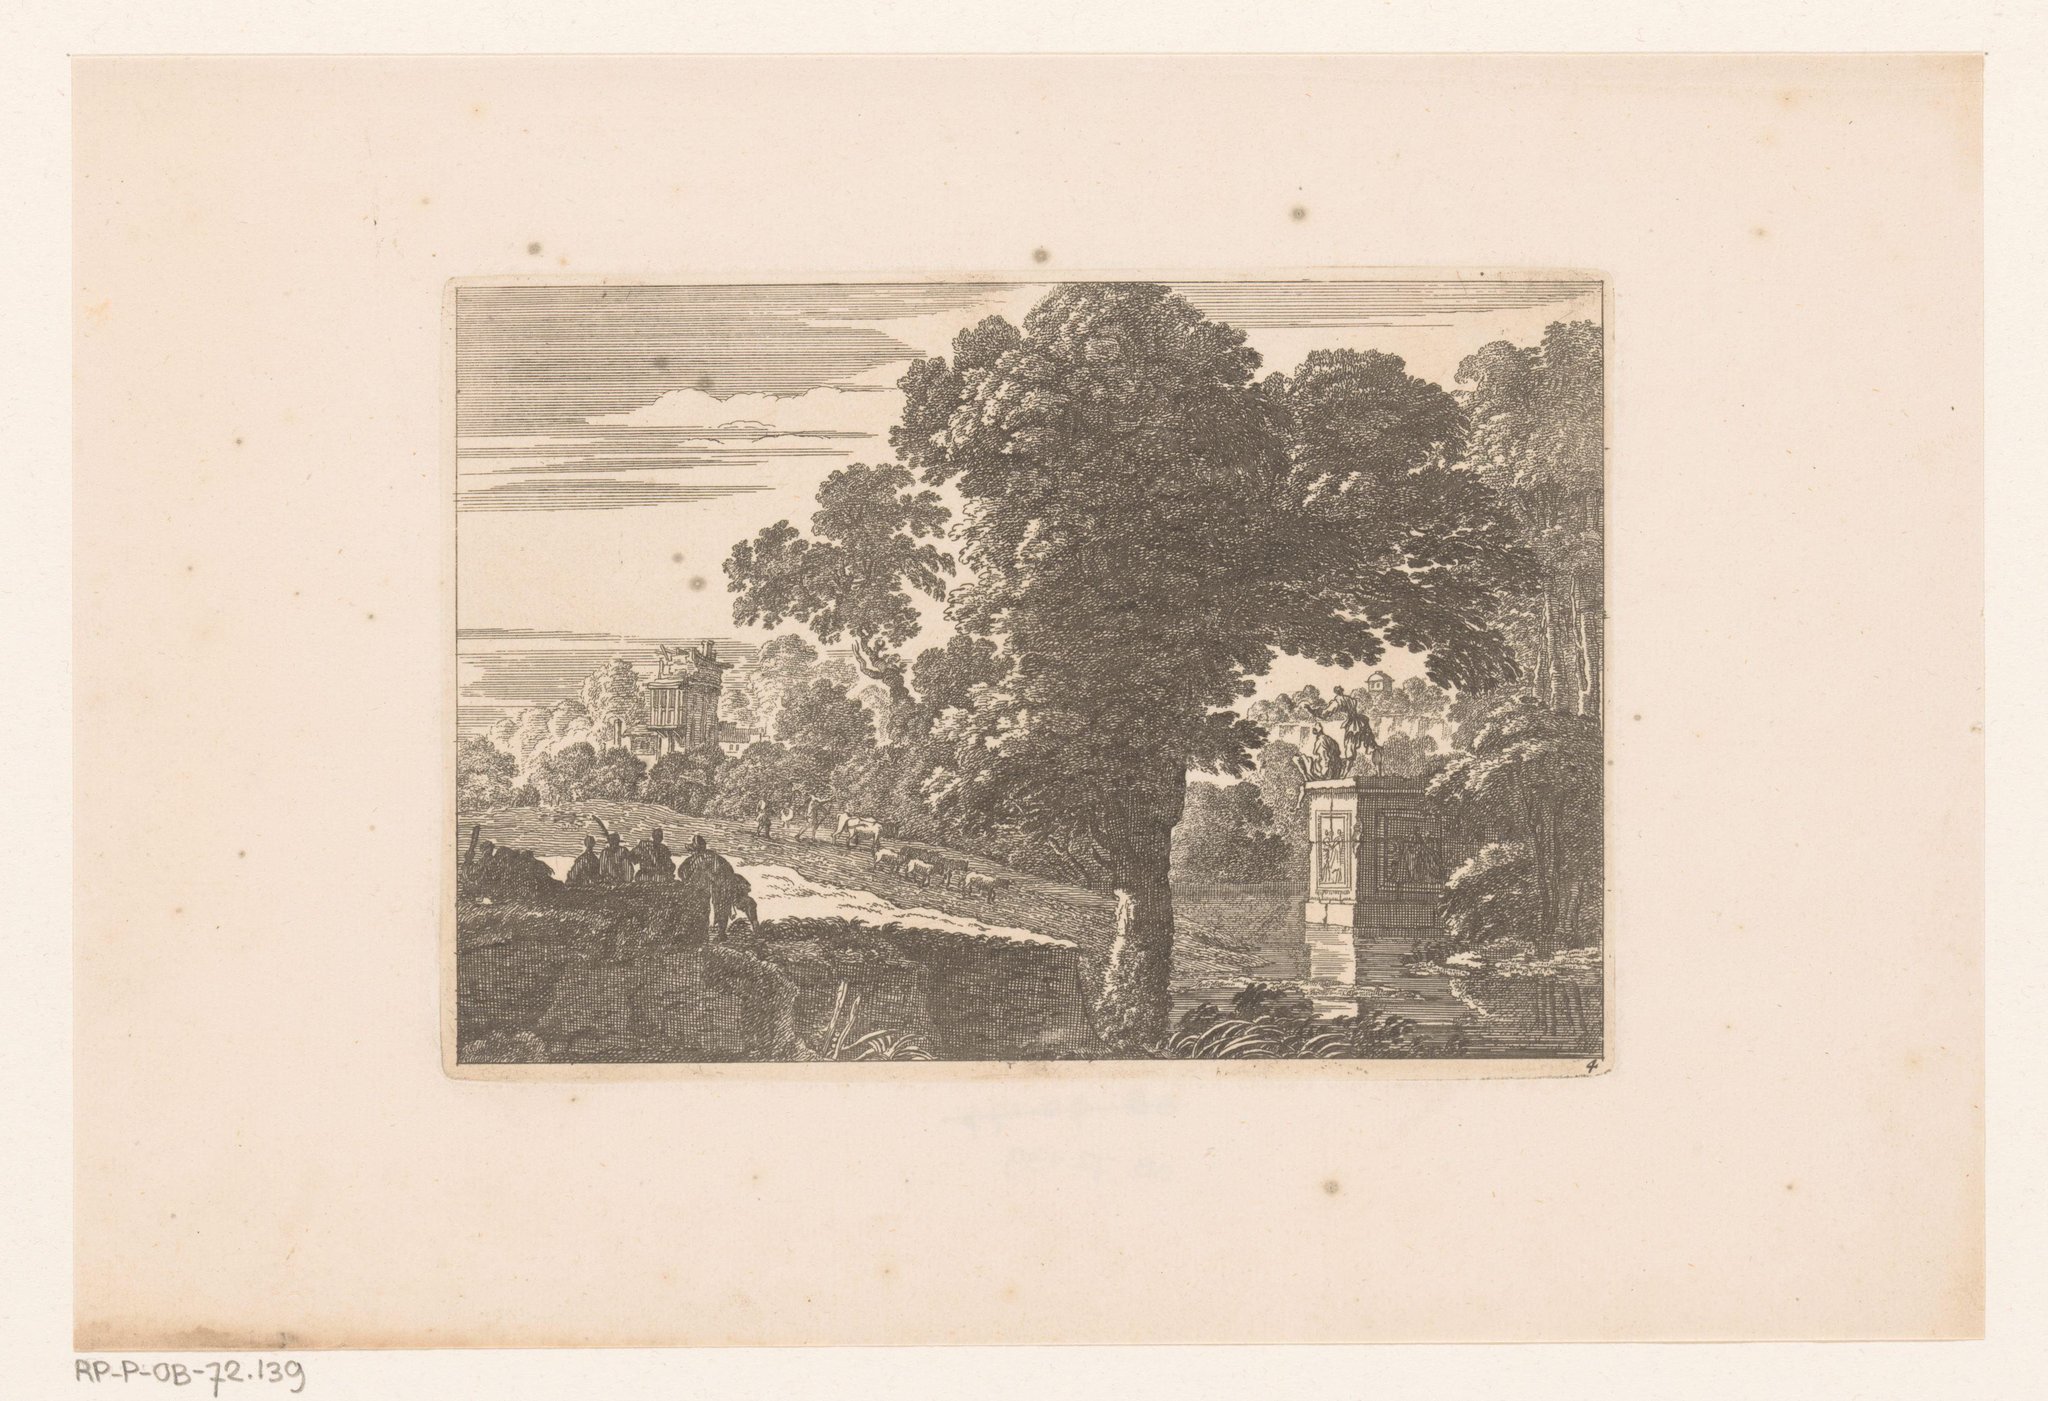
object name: print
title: Landschap met mannen op antieke vierkanten sokkel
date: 1613-1695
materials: paper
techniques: etching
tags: landscape with ruins, pedestal of a piece of sculpture (perhaps in the form of a herm)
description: Prenten met het signatuur 'Perelle' kunnen zowel door vader Gabriel als door zonen Nicolas en Adam gemaakt zijn.